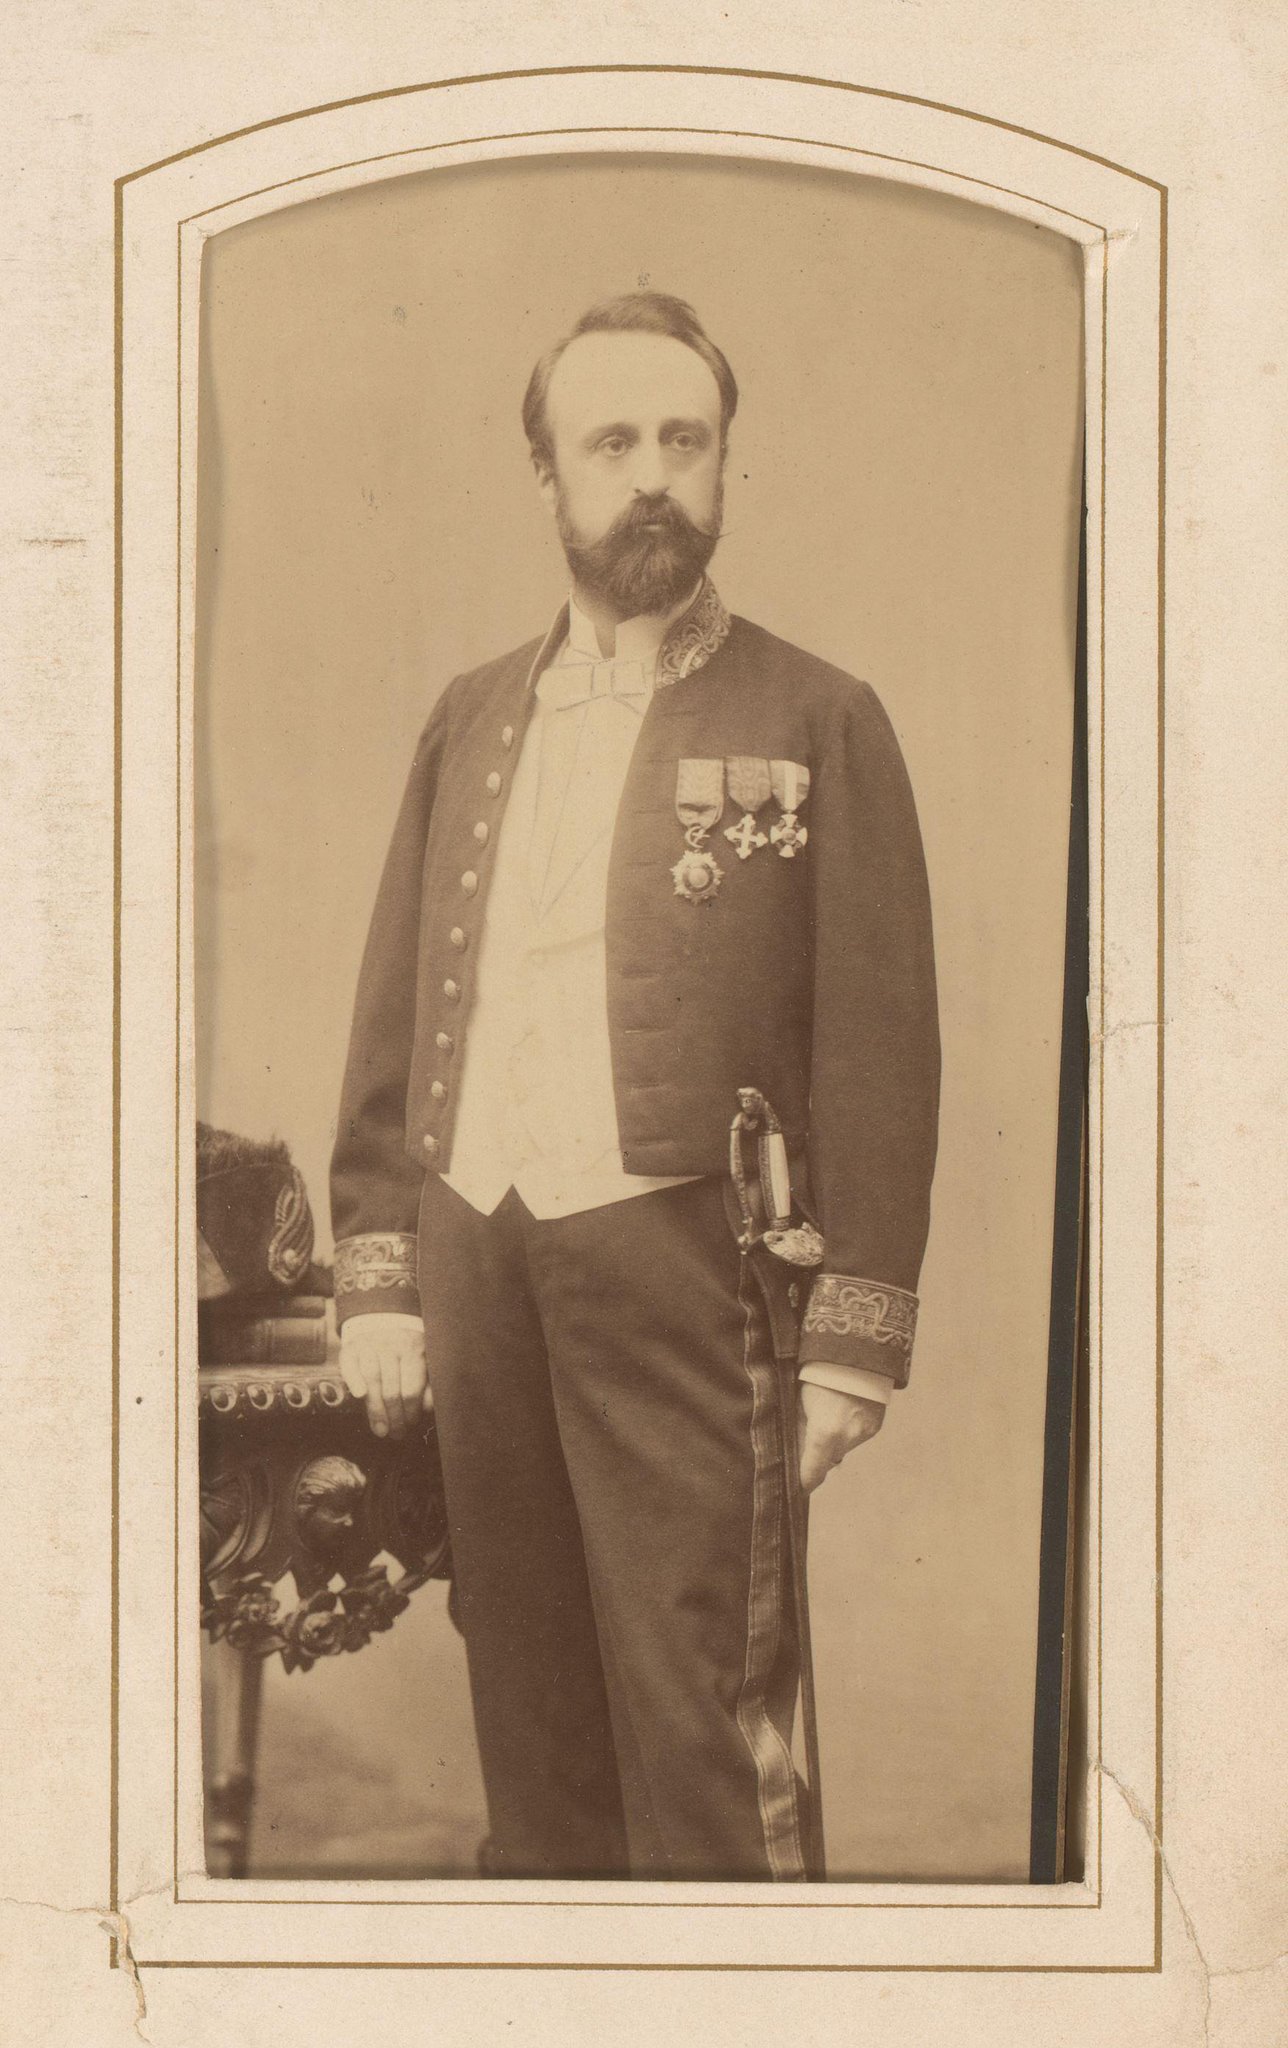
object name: photograph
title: Portret van een staande man in uniform met onderscheidingen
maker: ilario carposio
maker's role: fotograaf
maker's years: 1852-1921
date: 1880-1910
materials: cardboard, photographic support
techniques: albumen print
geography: europe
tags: historical persons, medals and other marks of military honour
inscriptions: inscription: ‘Illario Carposio/ Fiume’, inscription: ‘Carposio/ Fiume via. St. Andrea’